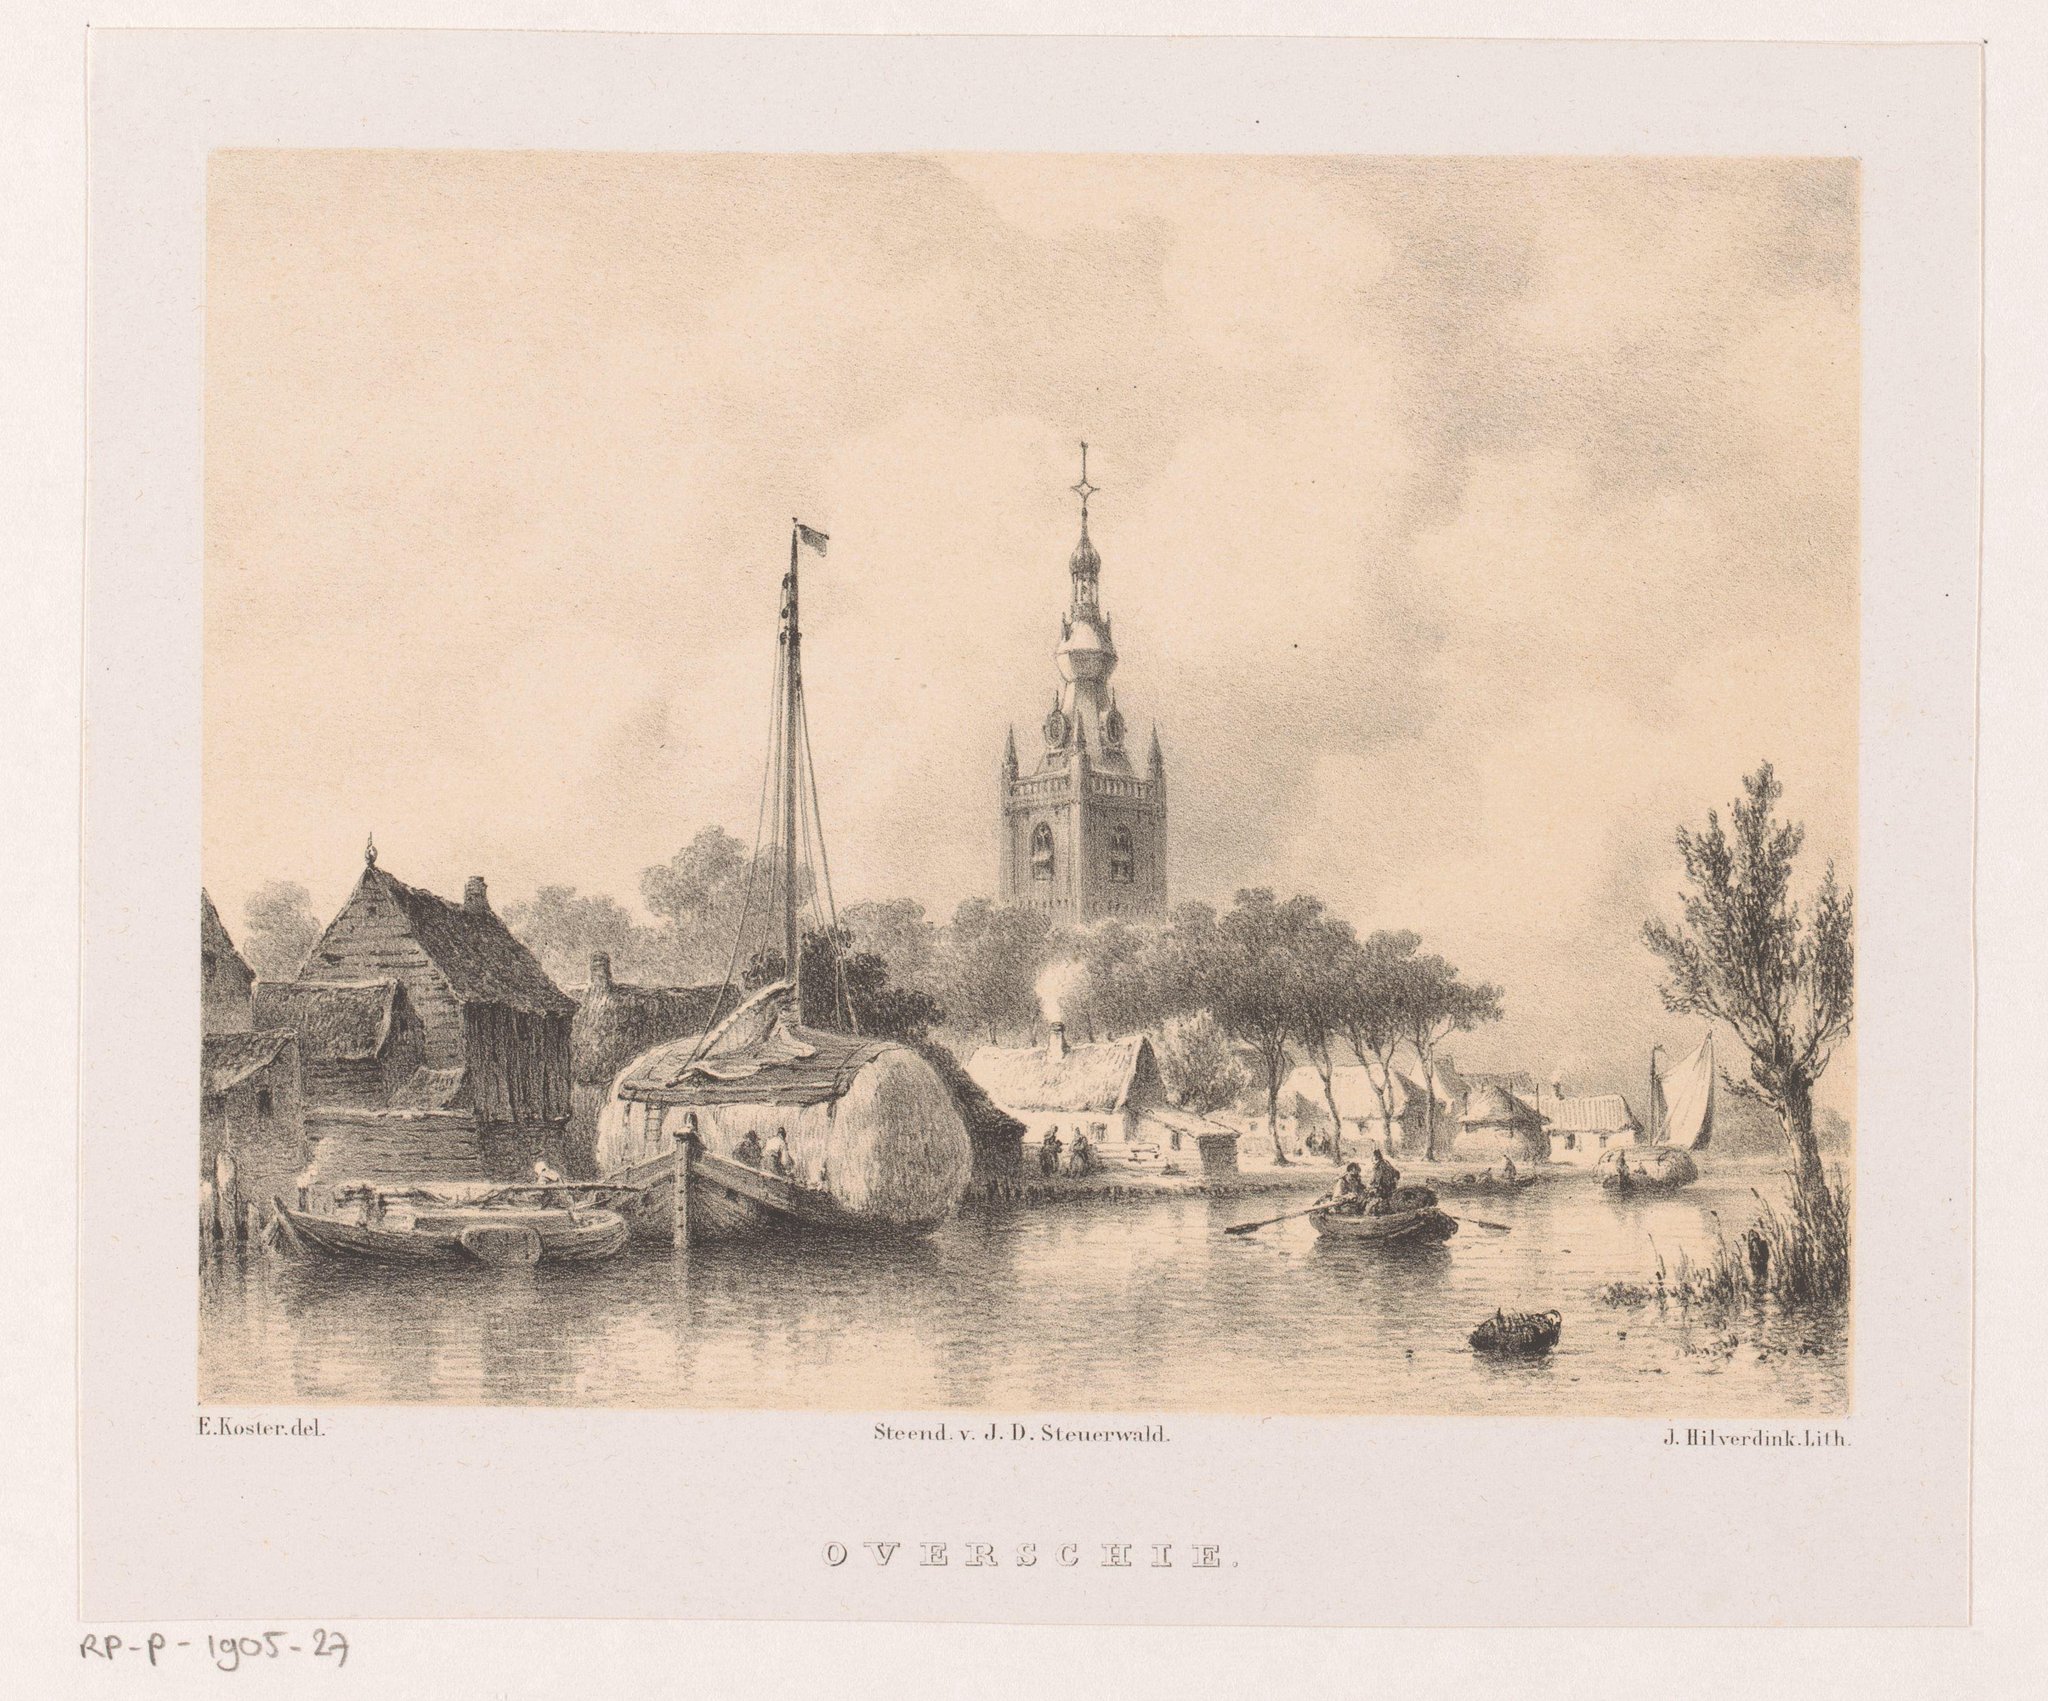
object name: print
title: Gezicht op Overschie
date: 1858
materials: paper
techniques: tone lithography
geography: amsterdam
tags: agricultural products and by-products: hay, city-view, and landscape with man-made constructions (+ city(-scape) with figures, staffage), parts of church exterior and annexes: tower, overschie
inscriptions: collector's mark: Lugt 2228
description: Deze prent komt uit: Koster, E. 'E. Koster's schetsboek: Nederlandsche Stads- en Havengezichten, uitgegeven onder medewerking van de maatschappij Arti et Amicitiae, Amsterdam, F. Buffa en Zn., e.a.' Amsterdam 1858.